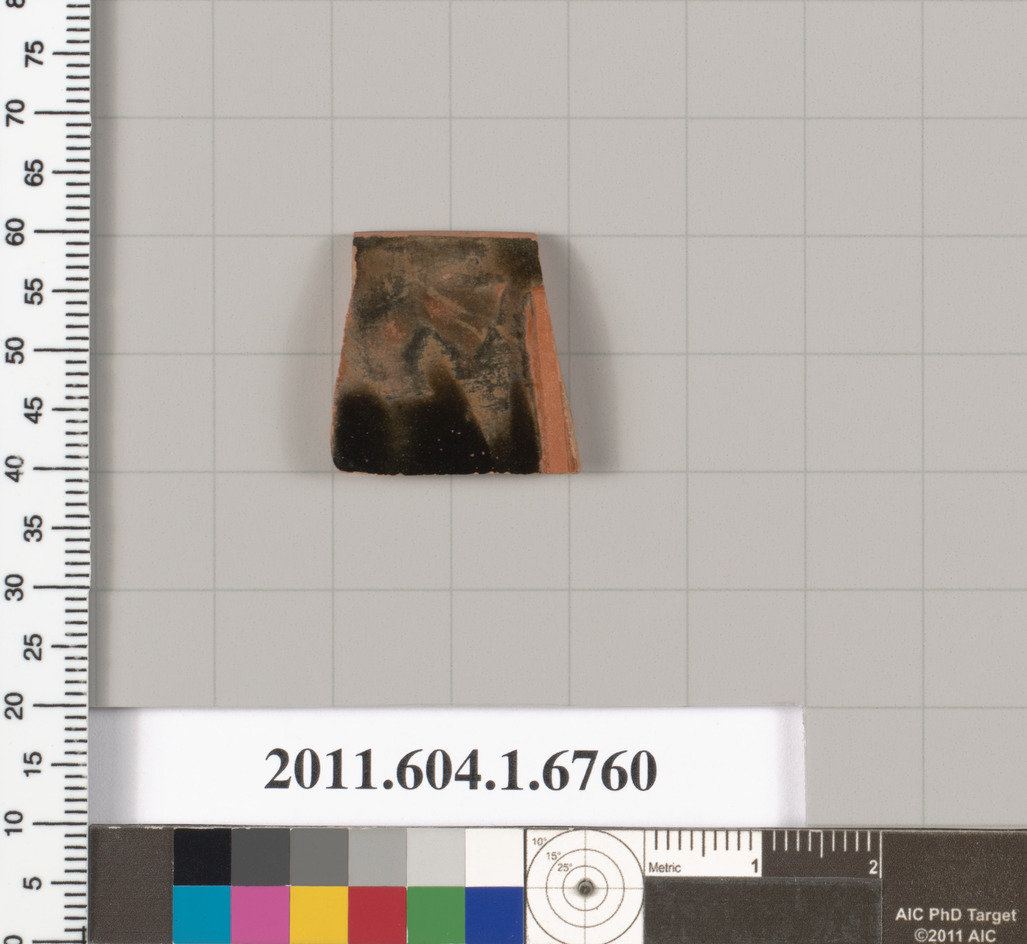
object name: kylix fragment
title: Terracotta rim fragment of a kylix (drinking cup)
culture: greek, attic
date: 490-470 BCE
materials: terracotta